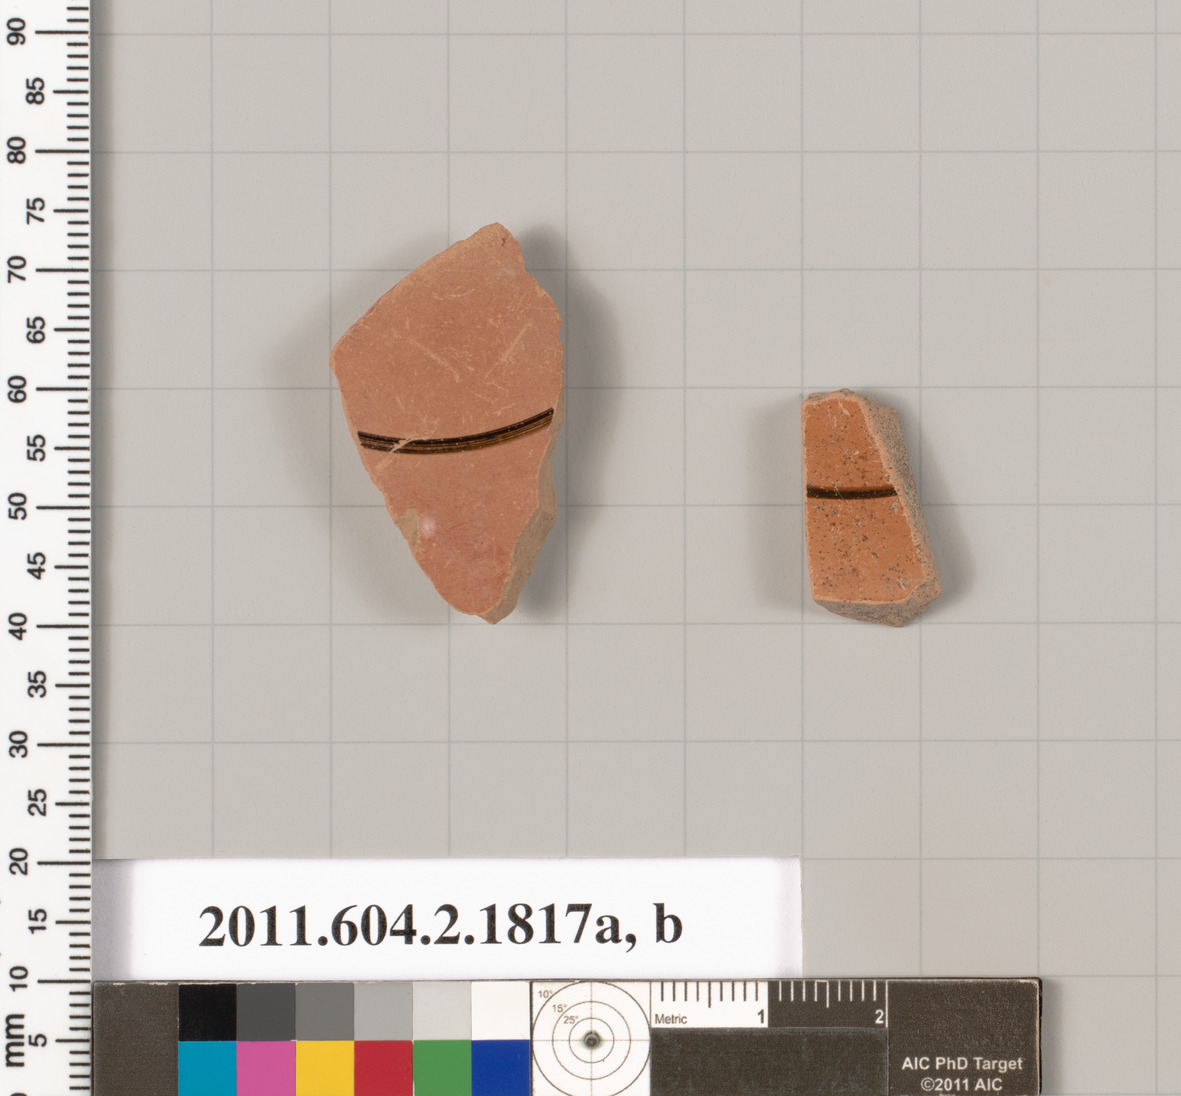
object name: skyphos fragment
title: Terracotta fragments of skyphoi (deep drinking cups)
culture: greek, attic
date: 450-401 BCE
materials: terracotta